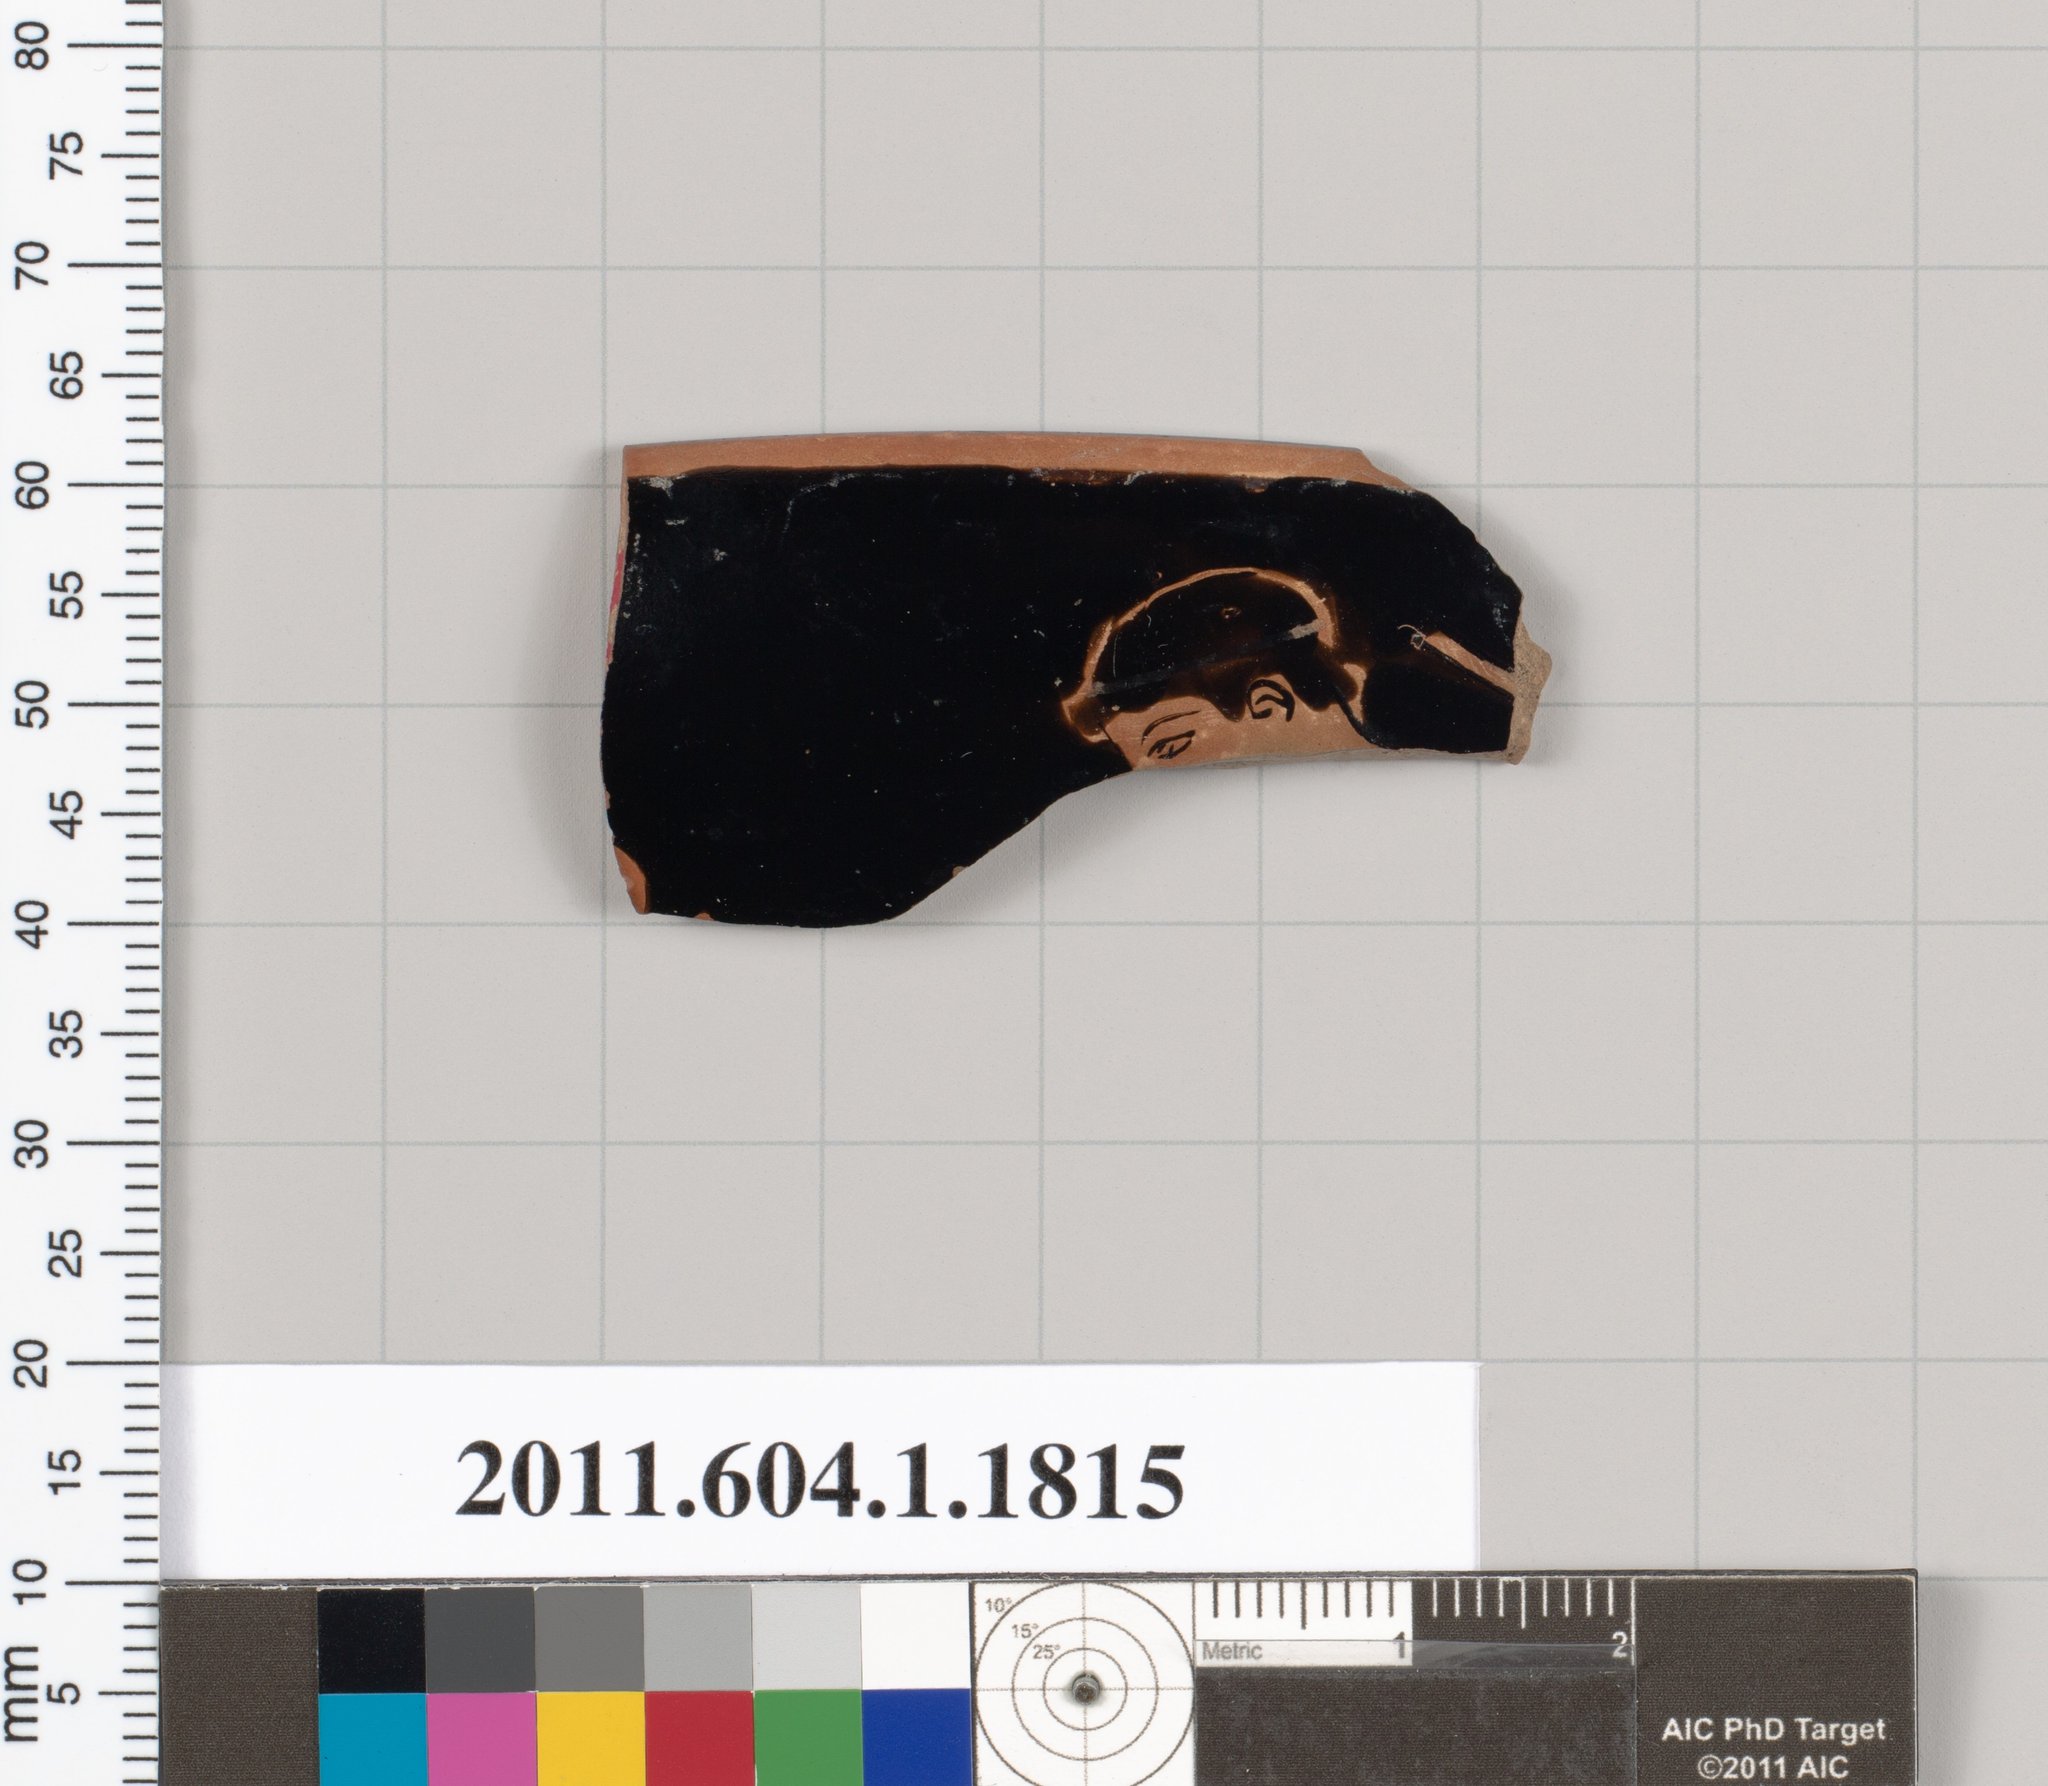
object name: kylix fragment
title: Terracotta rim fragment of a kylix (drinking cup)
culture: greek, attic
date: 490-480 BCE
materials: terracotta